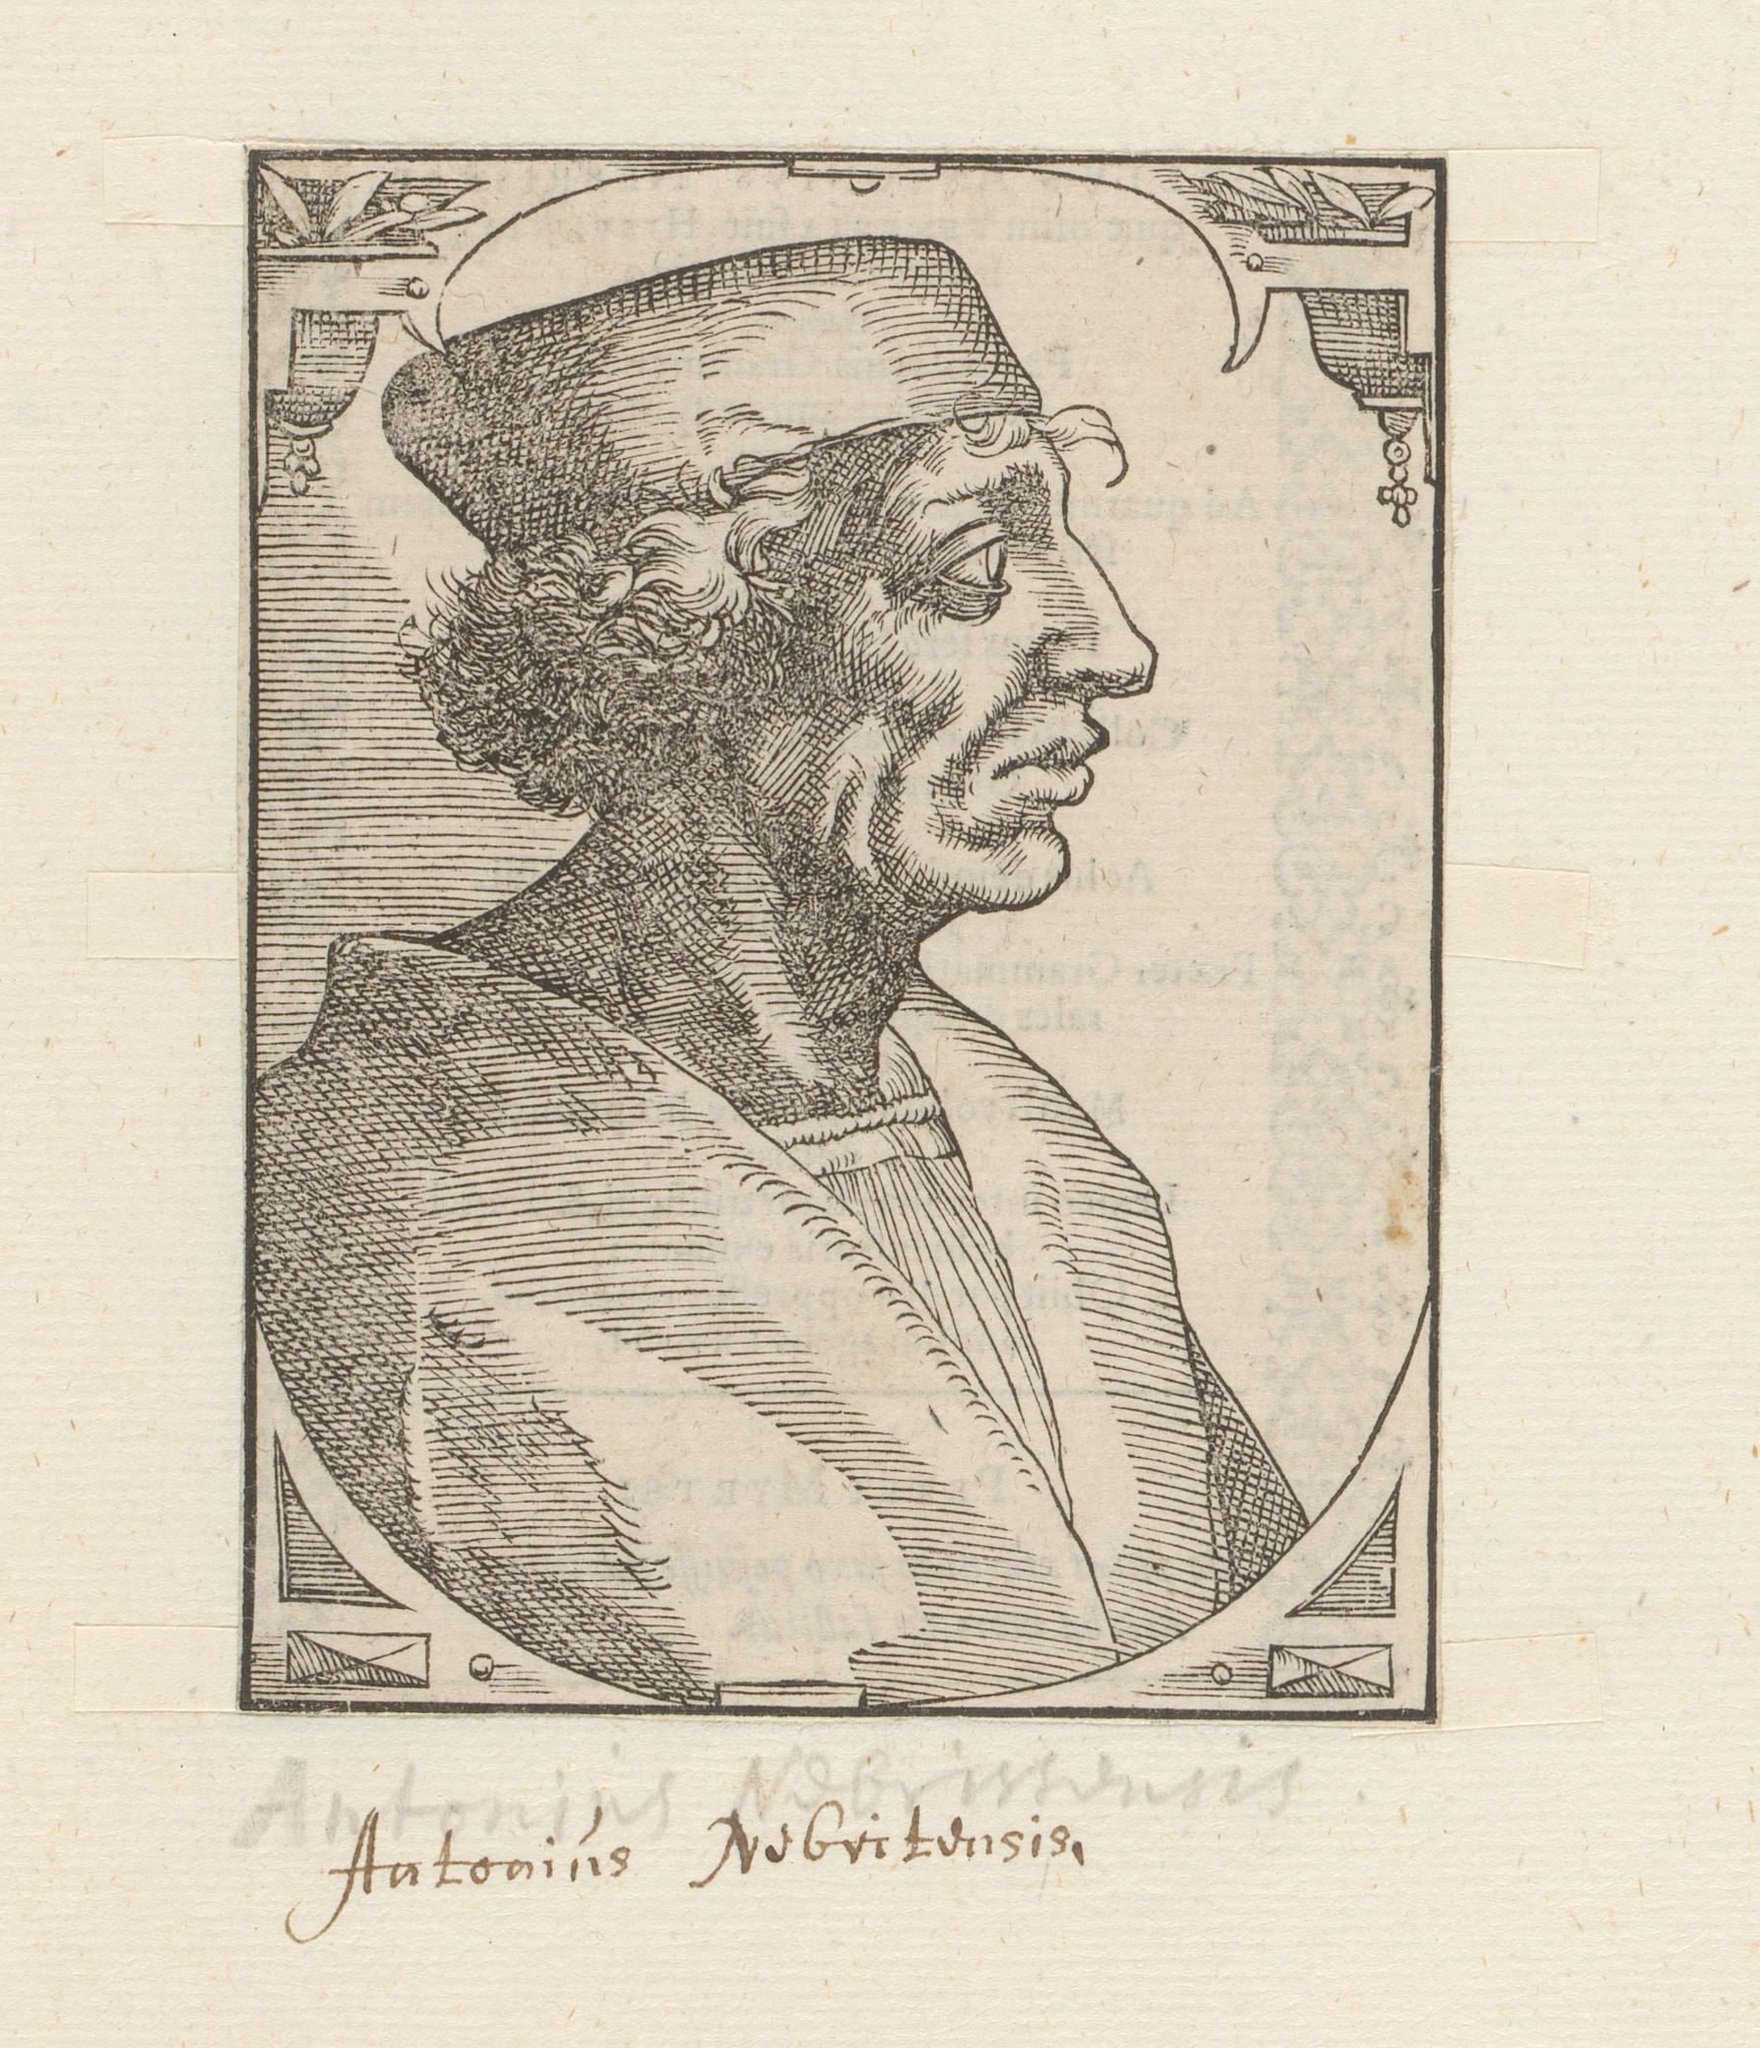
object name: album leaf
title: Portret van Antonio de Nebrija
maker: Anonymous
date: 1549-1577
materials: paper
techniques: letterpress printing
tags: historical persons, portrait of a writer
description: Prent gebruikt in: Giovio, Paolo. Elogia virorum literis illustrium (...). Bazel: Peter Perna, 1577.